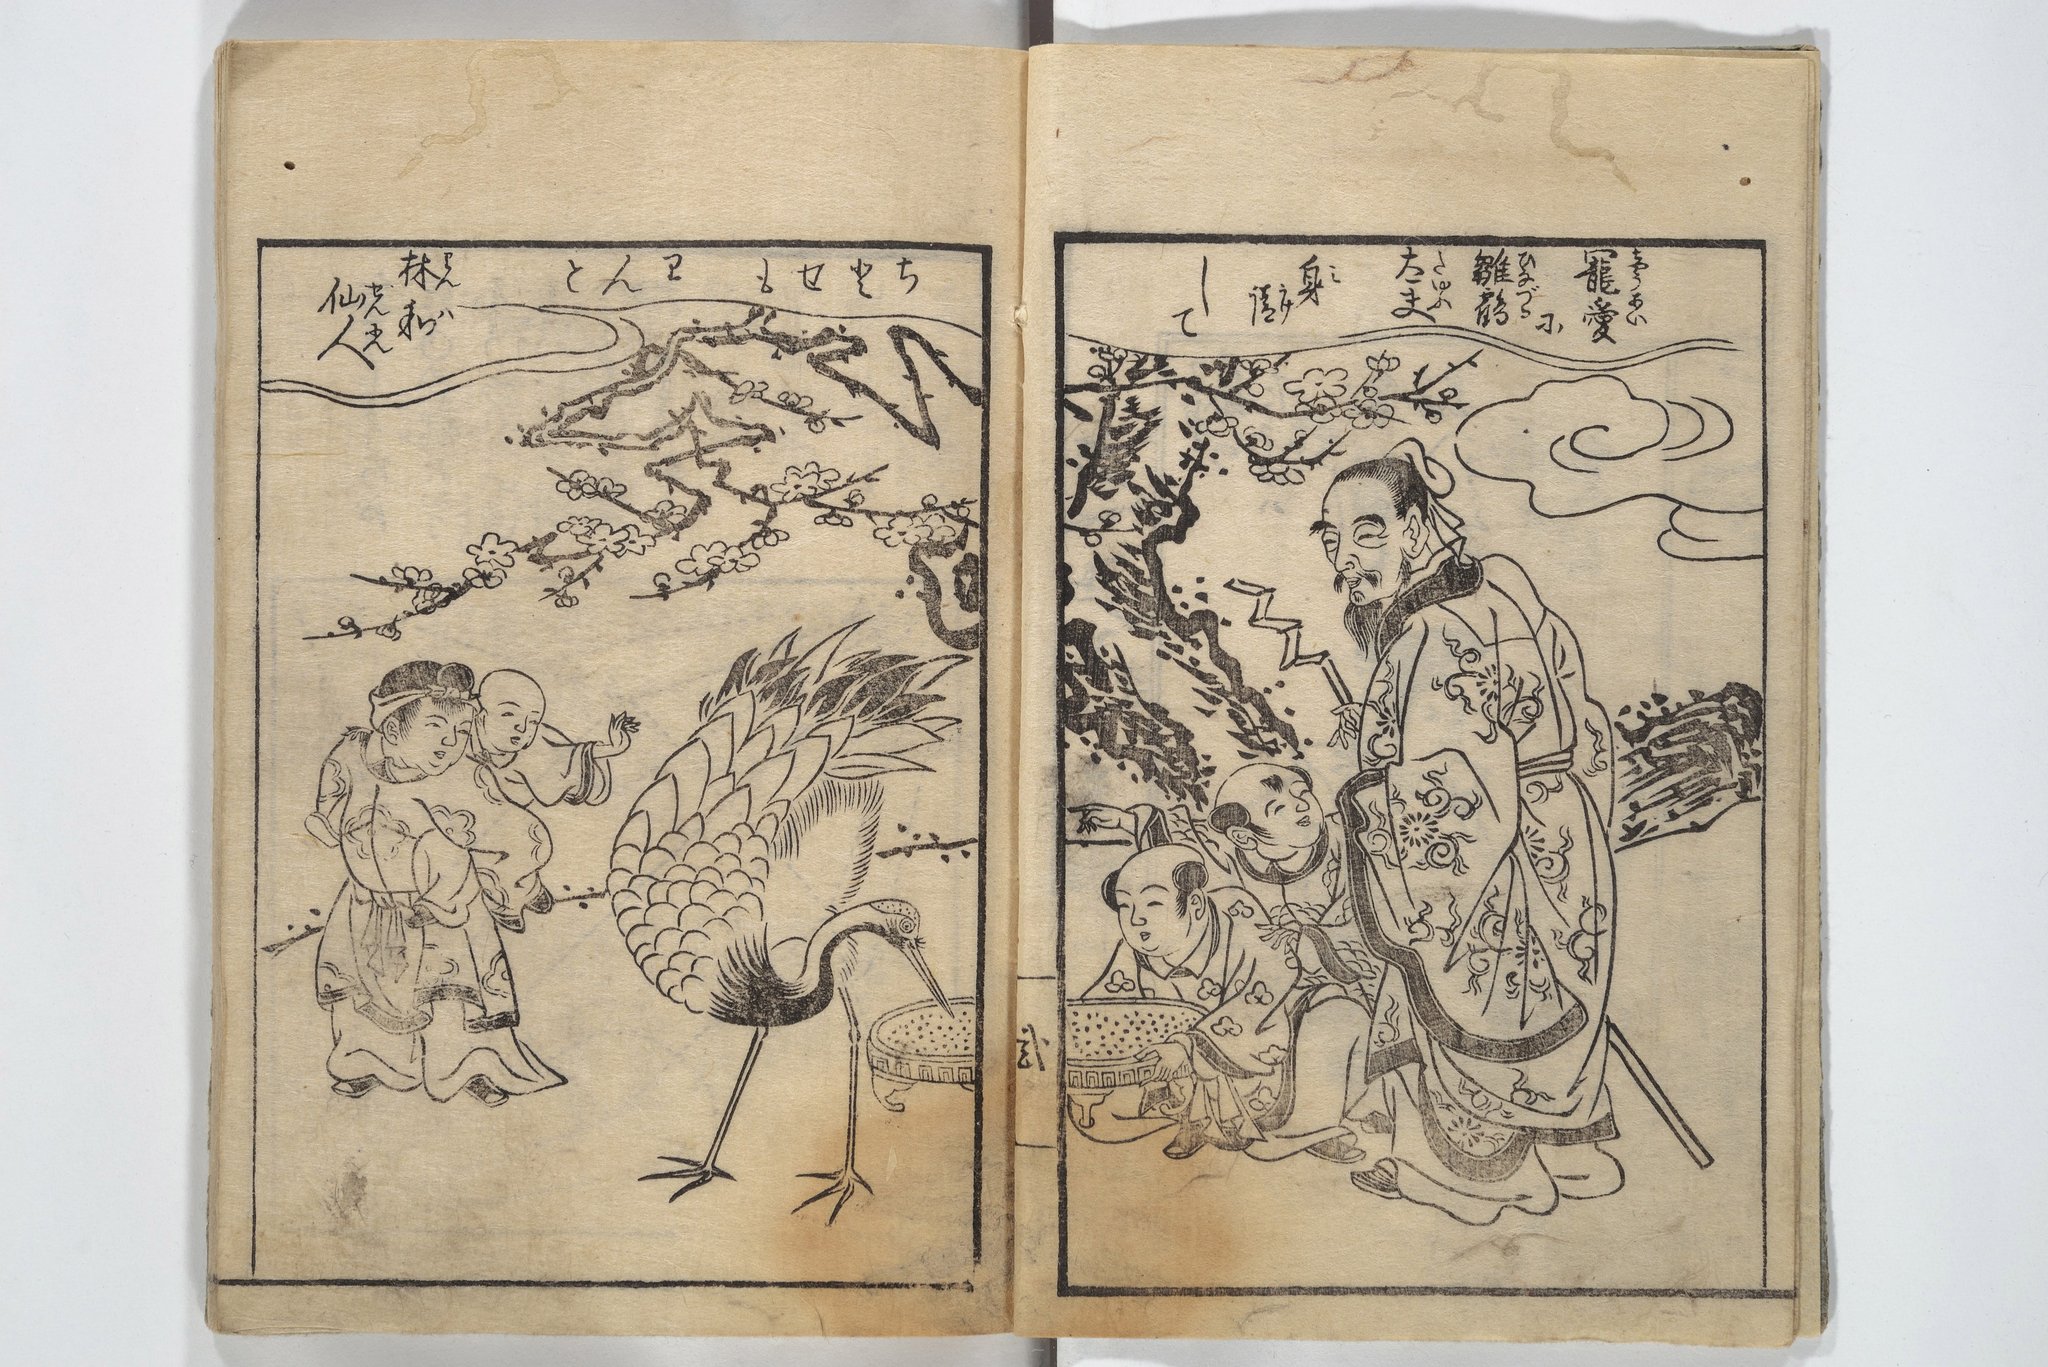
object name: illustrated book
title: A Thousand Cranes and How to Fold Them (Senbazuru orikata) 千羽鶴折形; 秘伝千羽鶴折形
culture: japanese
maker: shimokōbe shūsui 下河辺 拾水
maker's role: artist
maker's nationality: japanese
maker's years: -1797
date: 1797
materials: ink, paper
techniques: woodblock print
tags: cranes,boys,men,flowers